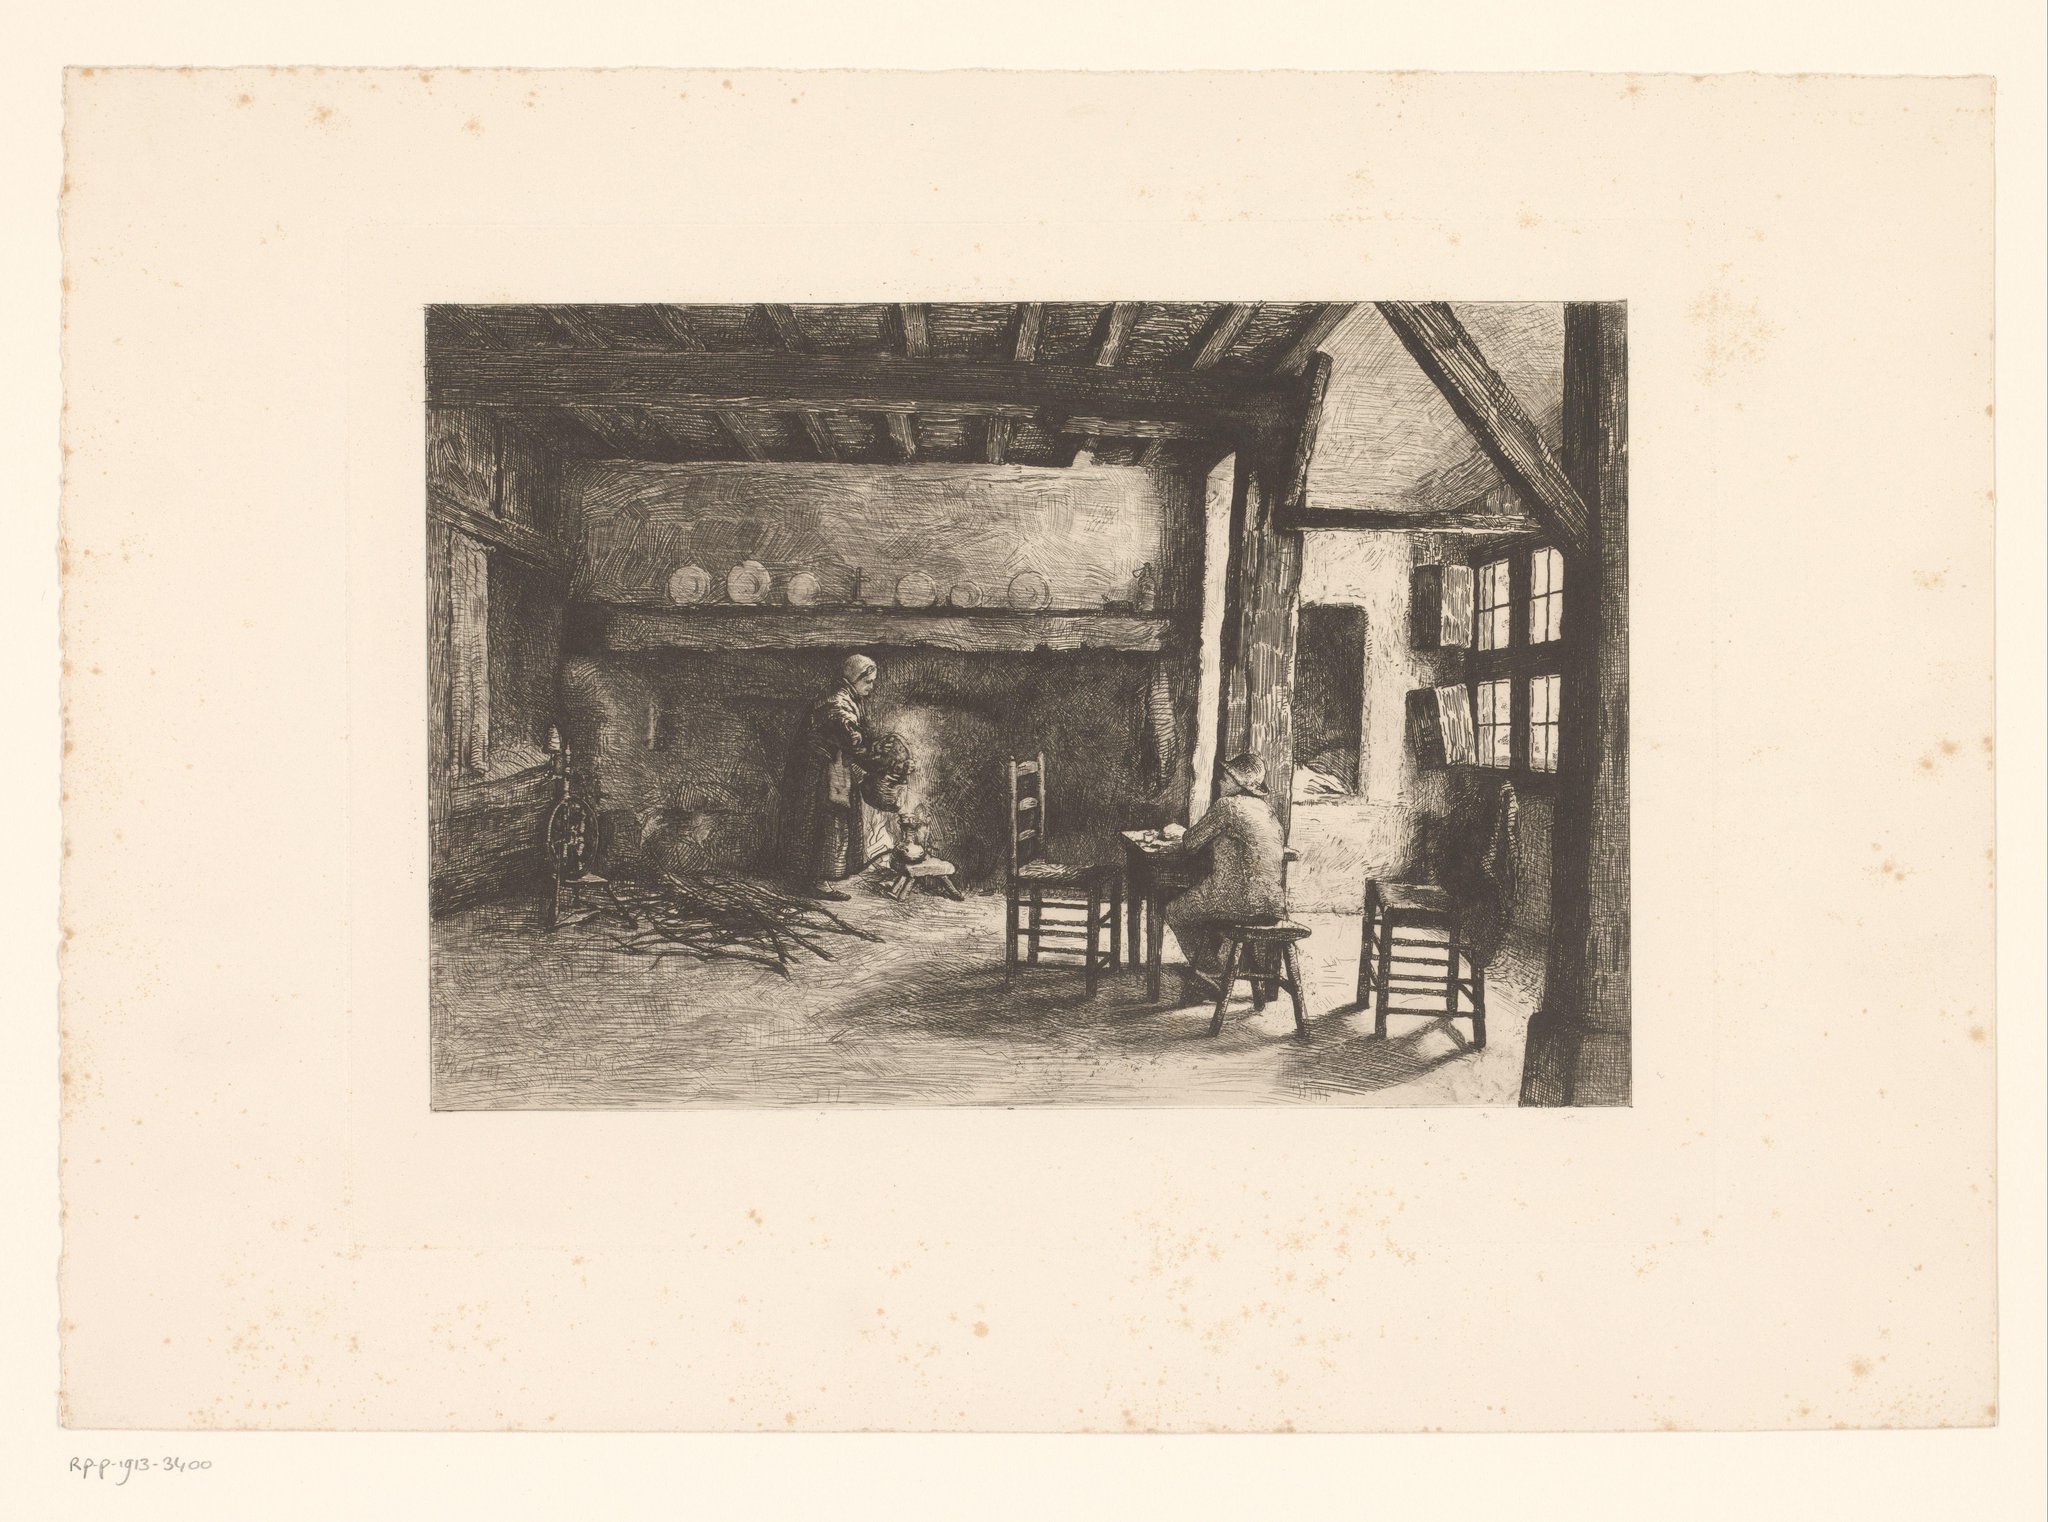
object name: print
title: Interieur van een boerenwoning met vrouw bij de haard en een man aan tafel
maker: piet verhaert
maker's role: print maker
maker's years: 1852-1908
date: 1882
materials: paper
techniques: etching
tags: open hearth, fire-place, interior of the house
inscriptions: collector's mark: Lugt 2228